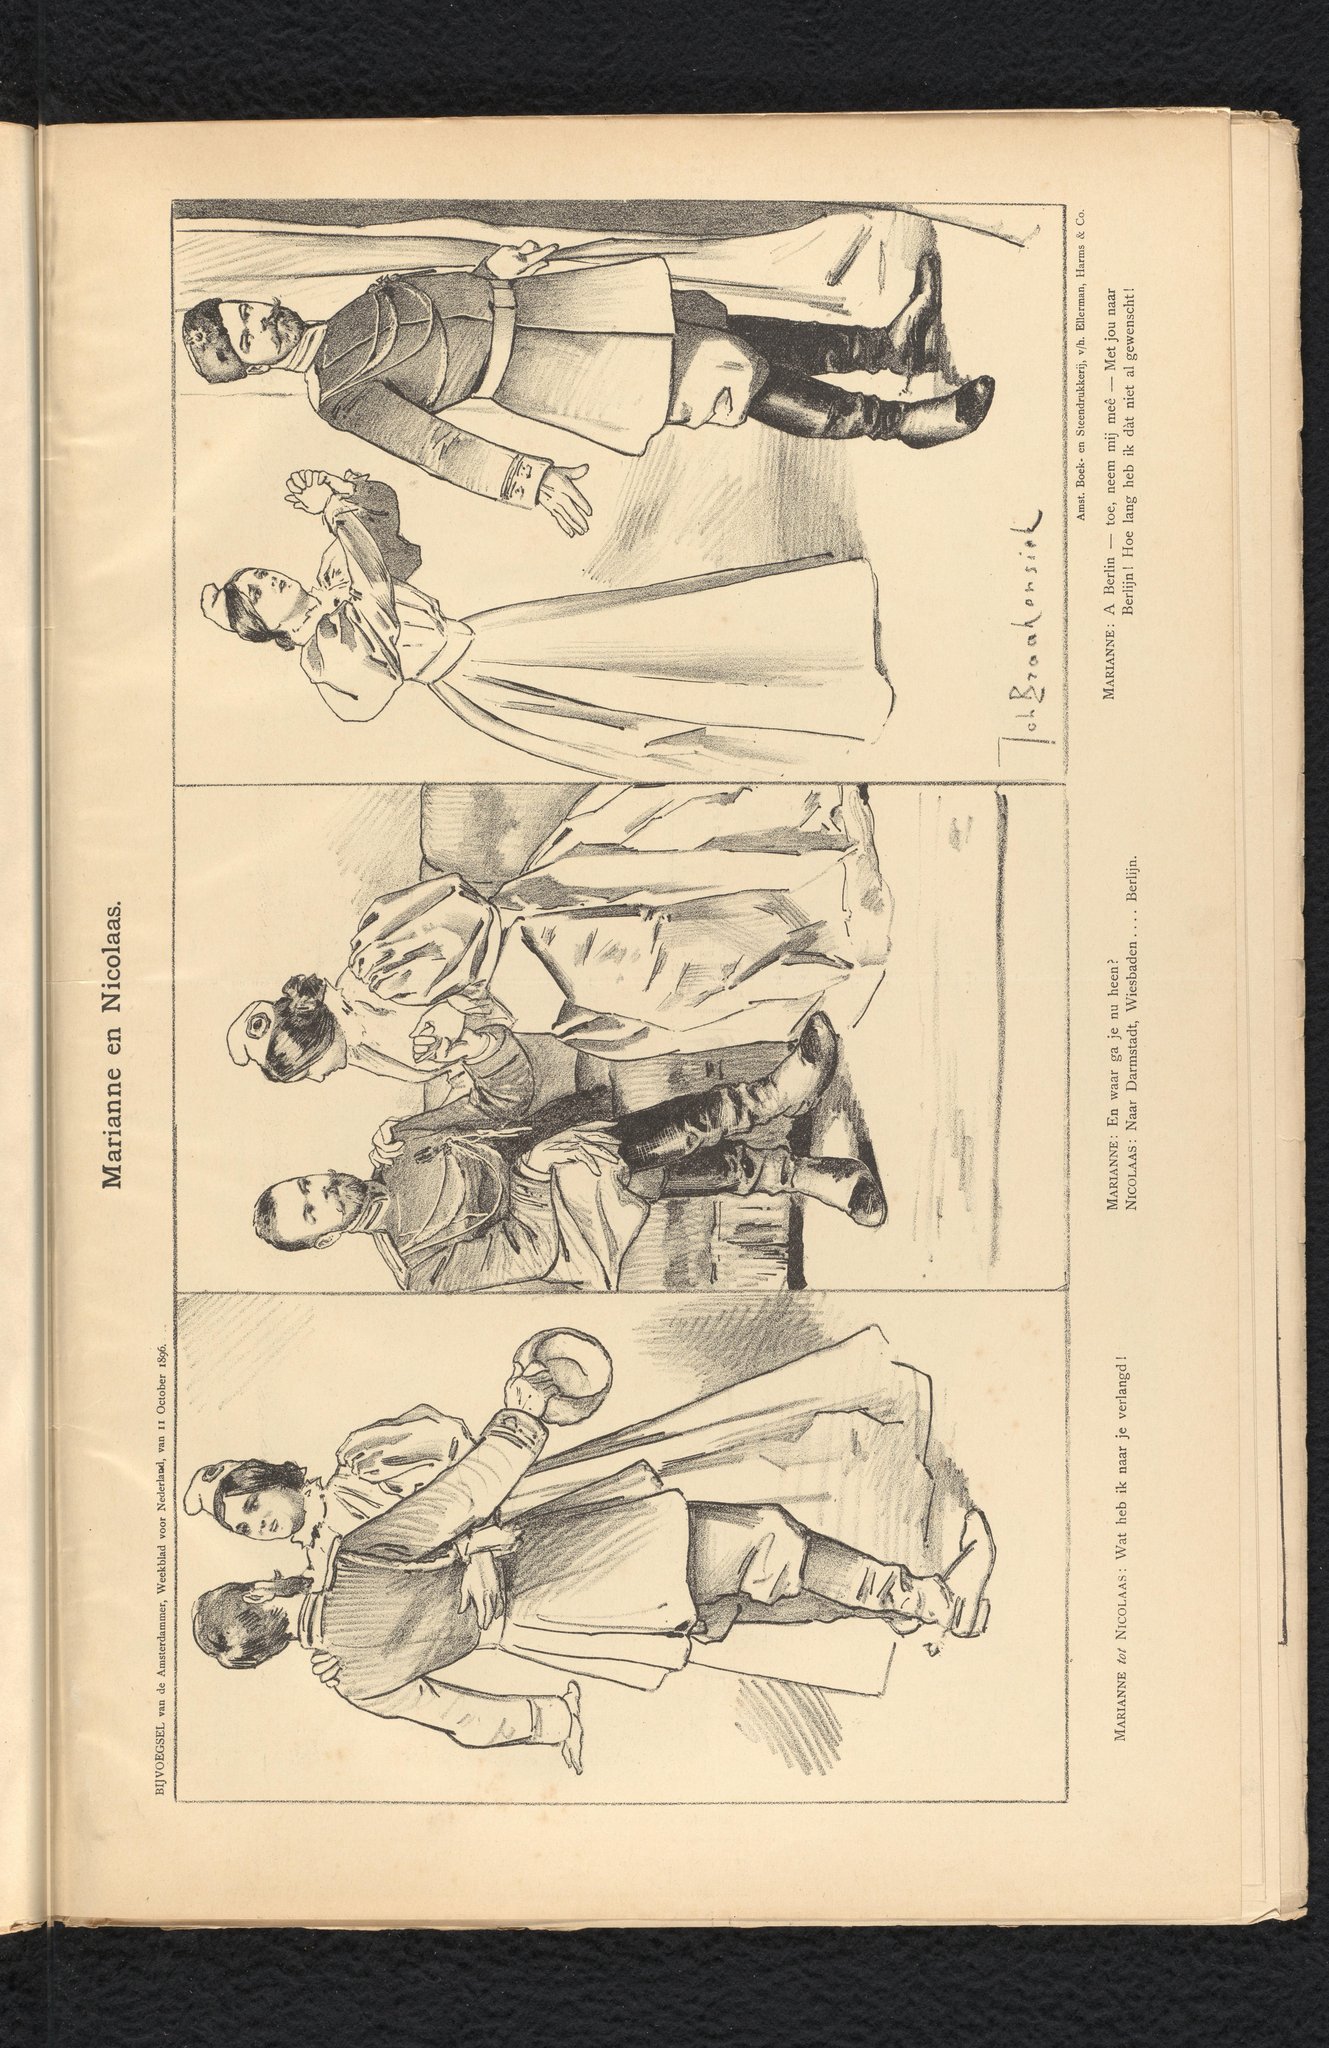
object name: cartoon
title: Marianne en Nicolaas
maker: johan braakensiek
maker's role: draughtsman, print maker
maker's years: 1858-1940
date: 1896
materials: paper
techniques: lithograph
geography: amsterdam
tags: personifications of countries, nations, states, districts, etc., group of actors, troupe; actors on the stage, lovers; courting, flirting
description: Drie scènes uit het liefdesdrama 'Marianne en Nicolaas', over de relatie tussen Frankrijk en Rusland.